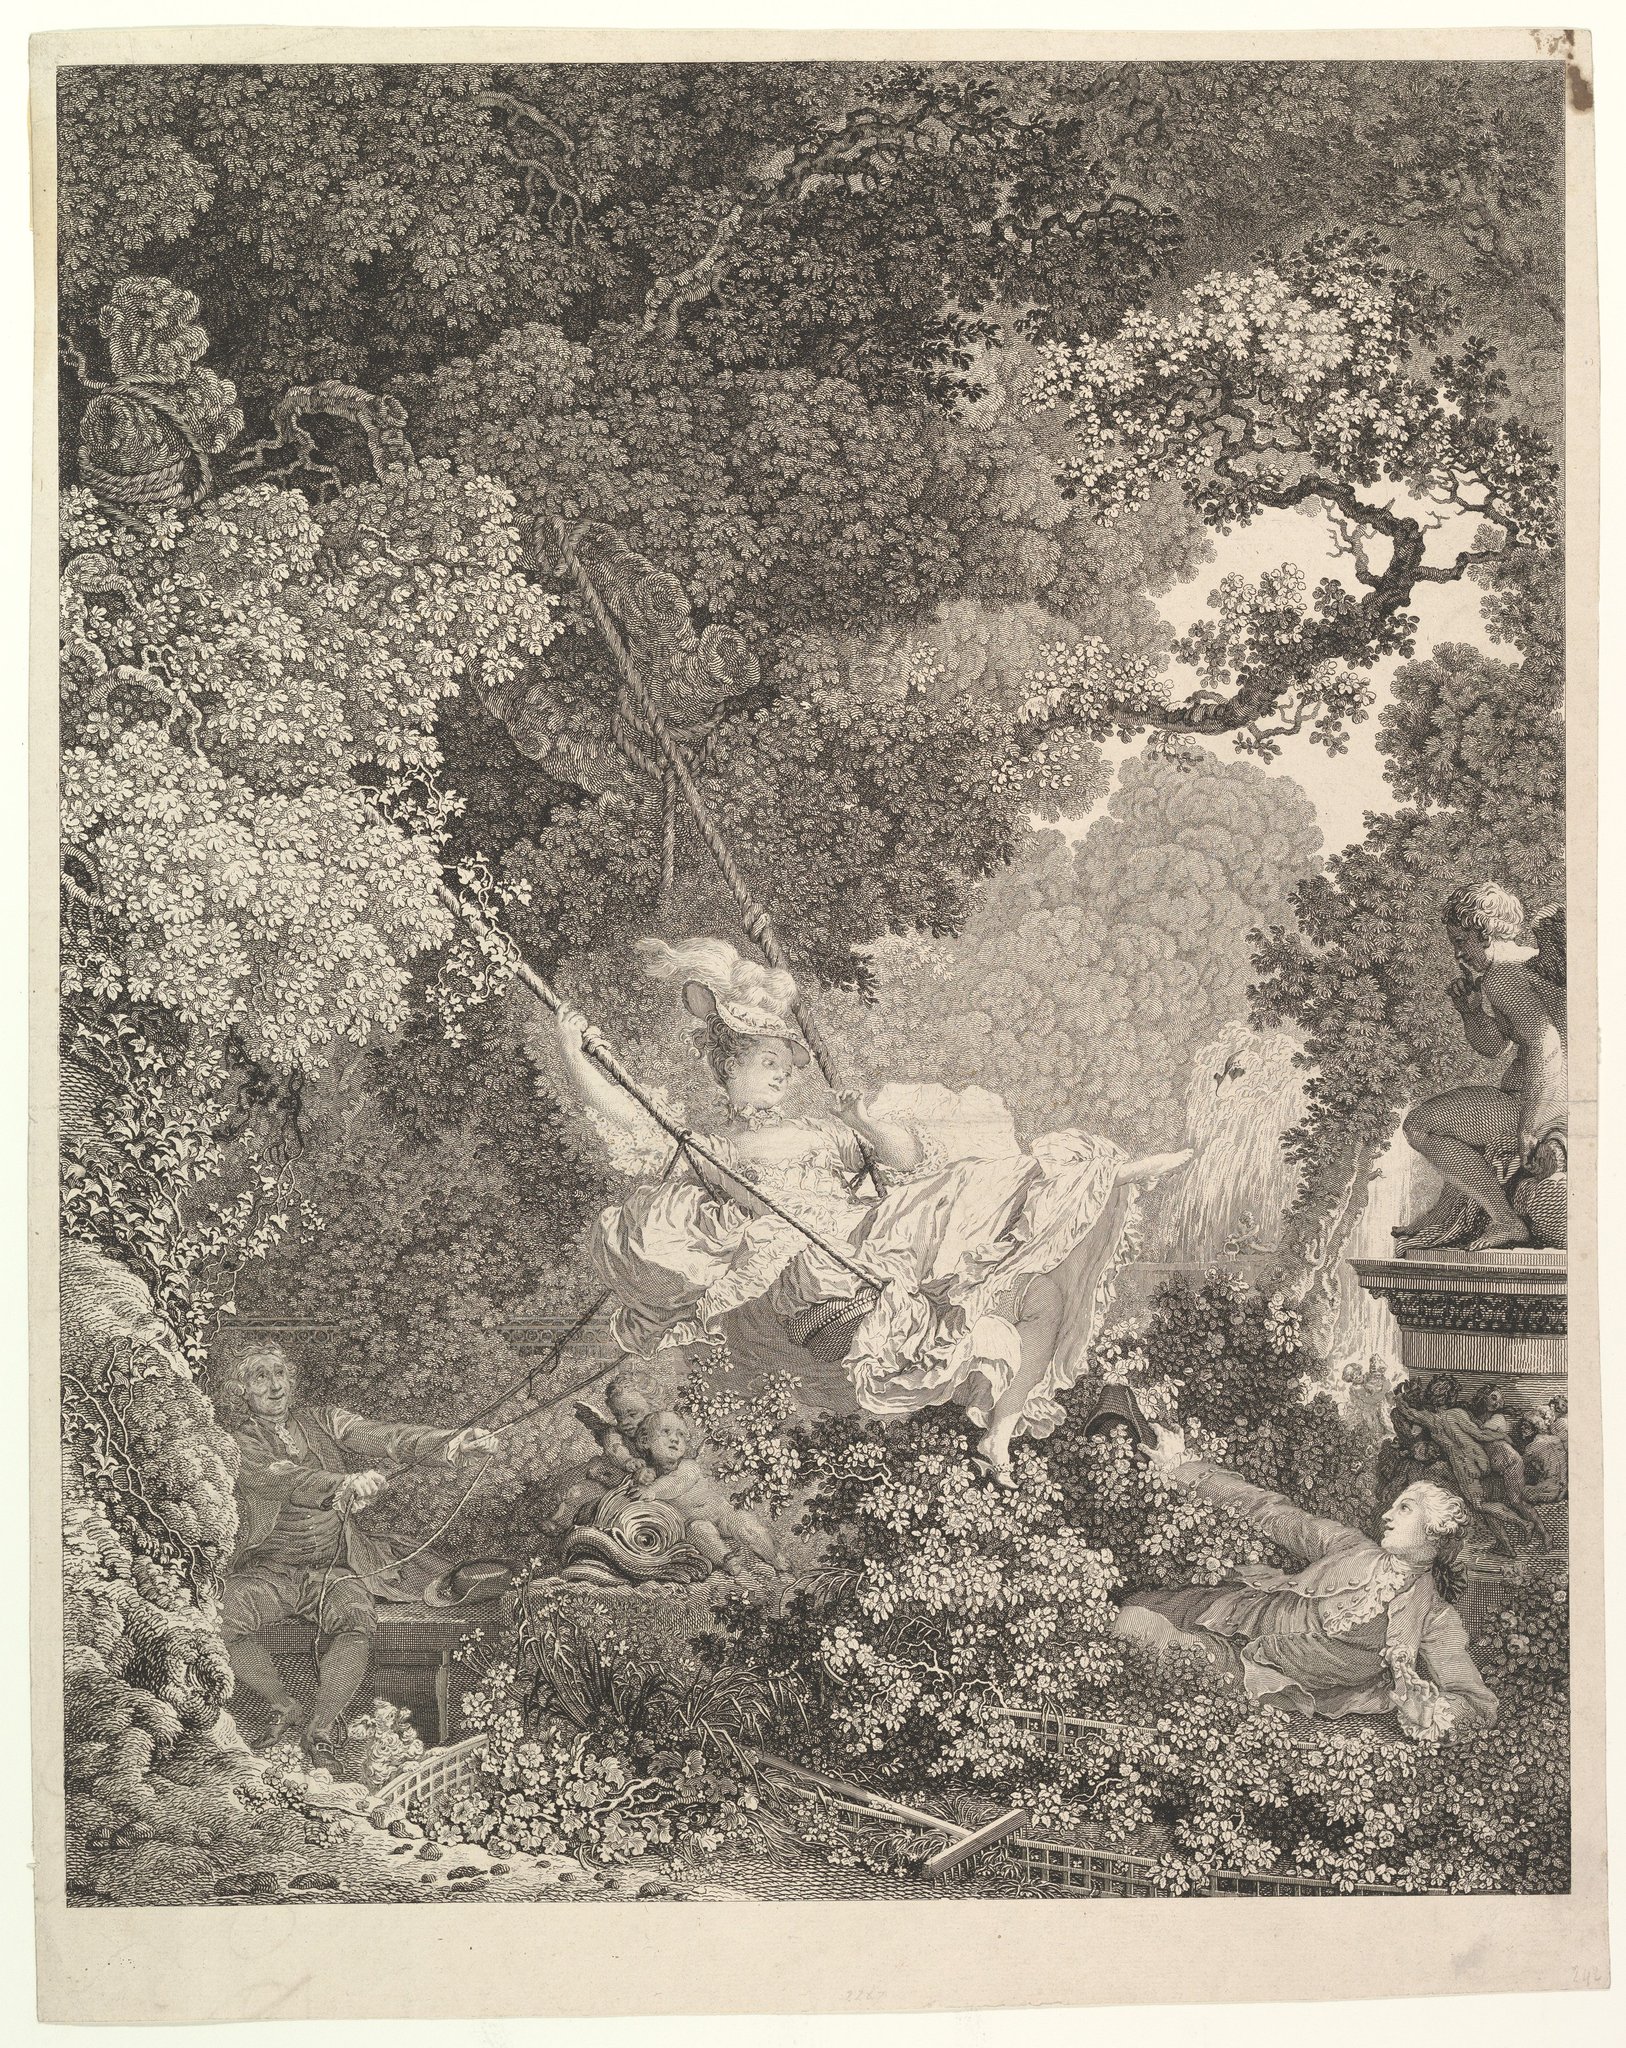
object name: print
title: Les Hazards heureux de l'Escarpolette (The Swing)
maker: jean honoré fragonard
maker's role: artist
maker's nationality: french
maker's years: 1732-1806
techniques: etching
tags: men,women,playing,trees